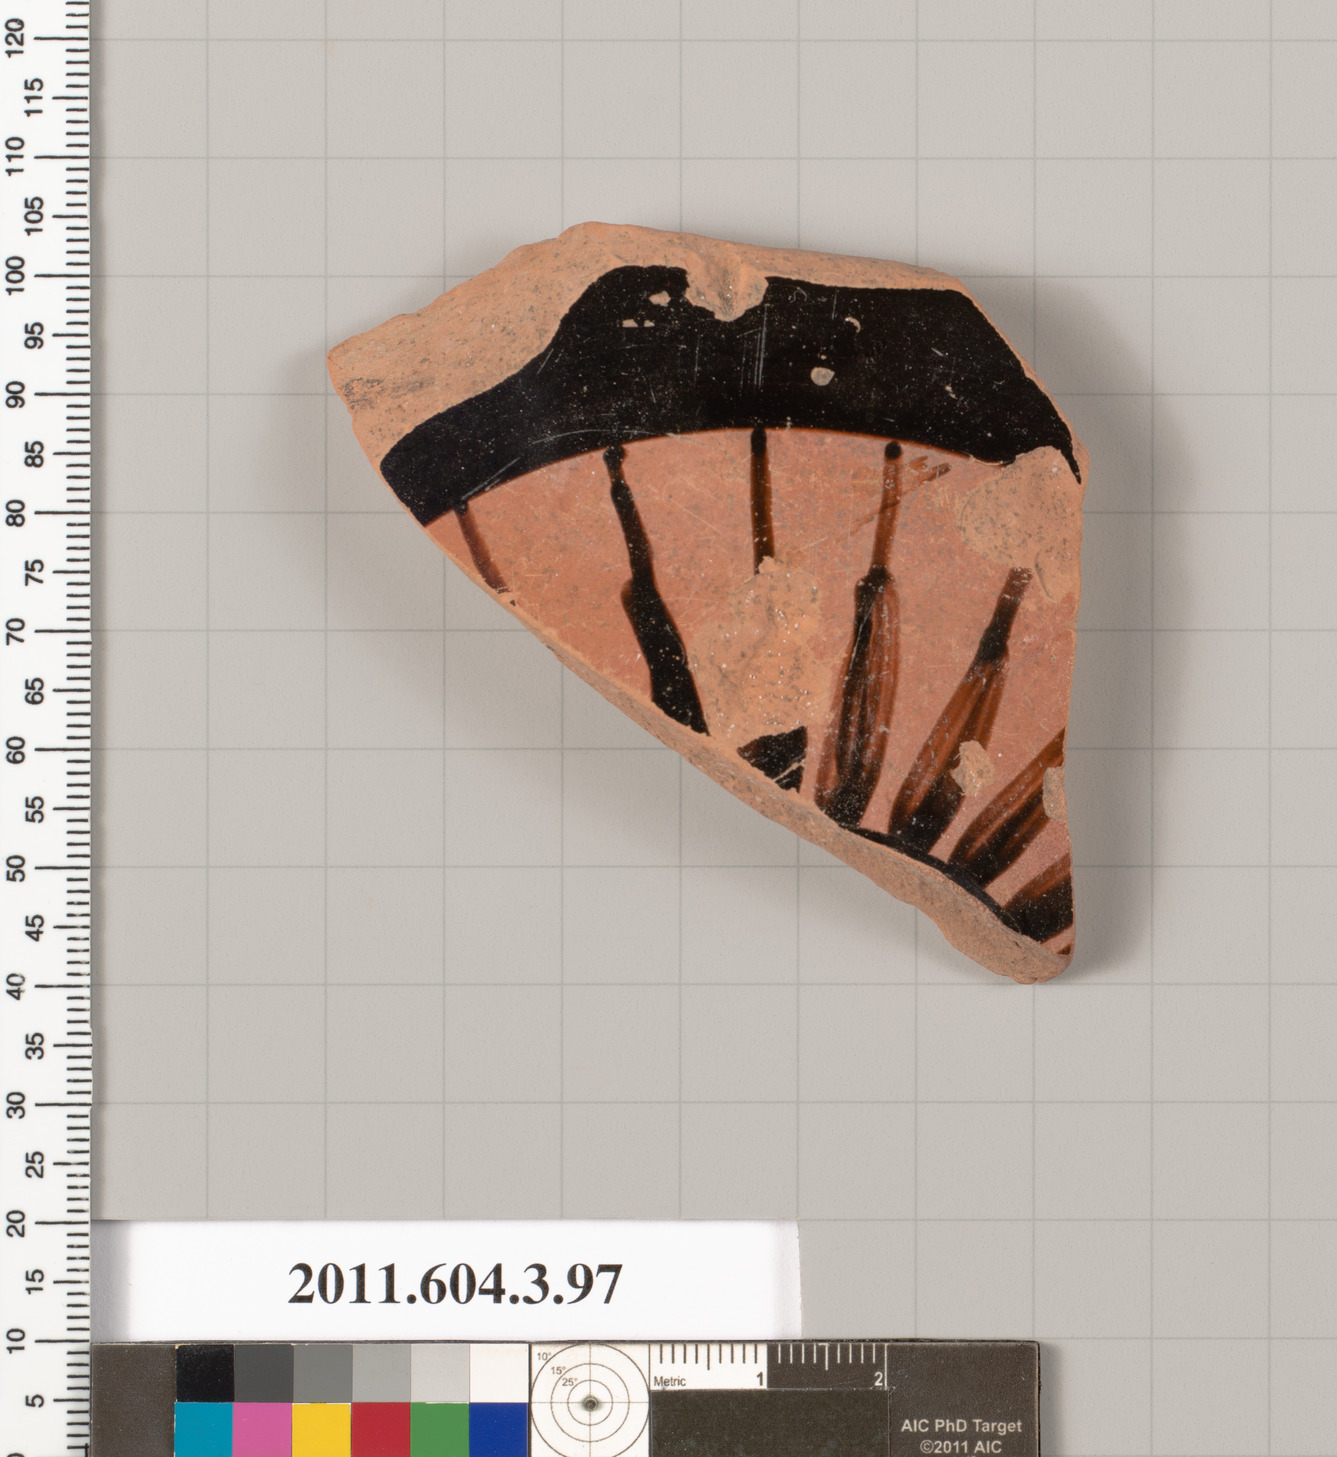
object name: amphora fragment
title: Terracotta fragment of an amphora (jar)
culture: greek, attic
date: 600-468 BCE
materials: terracotta